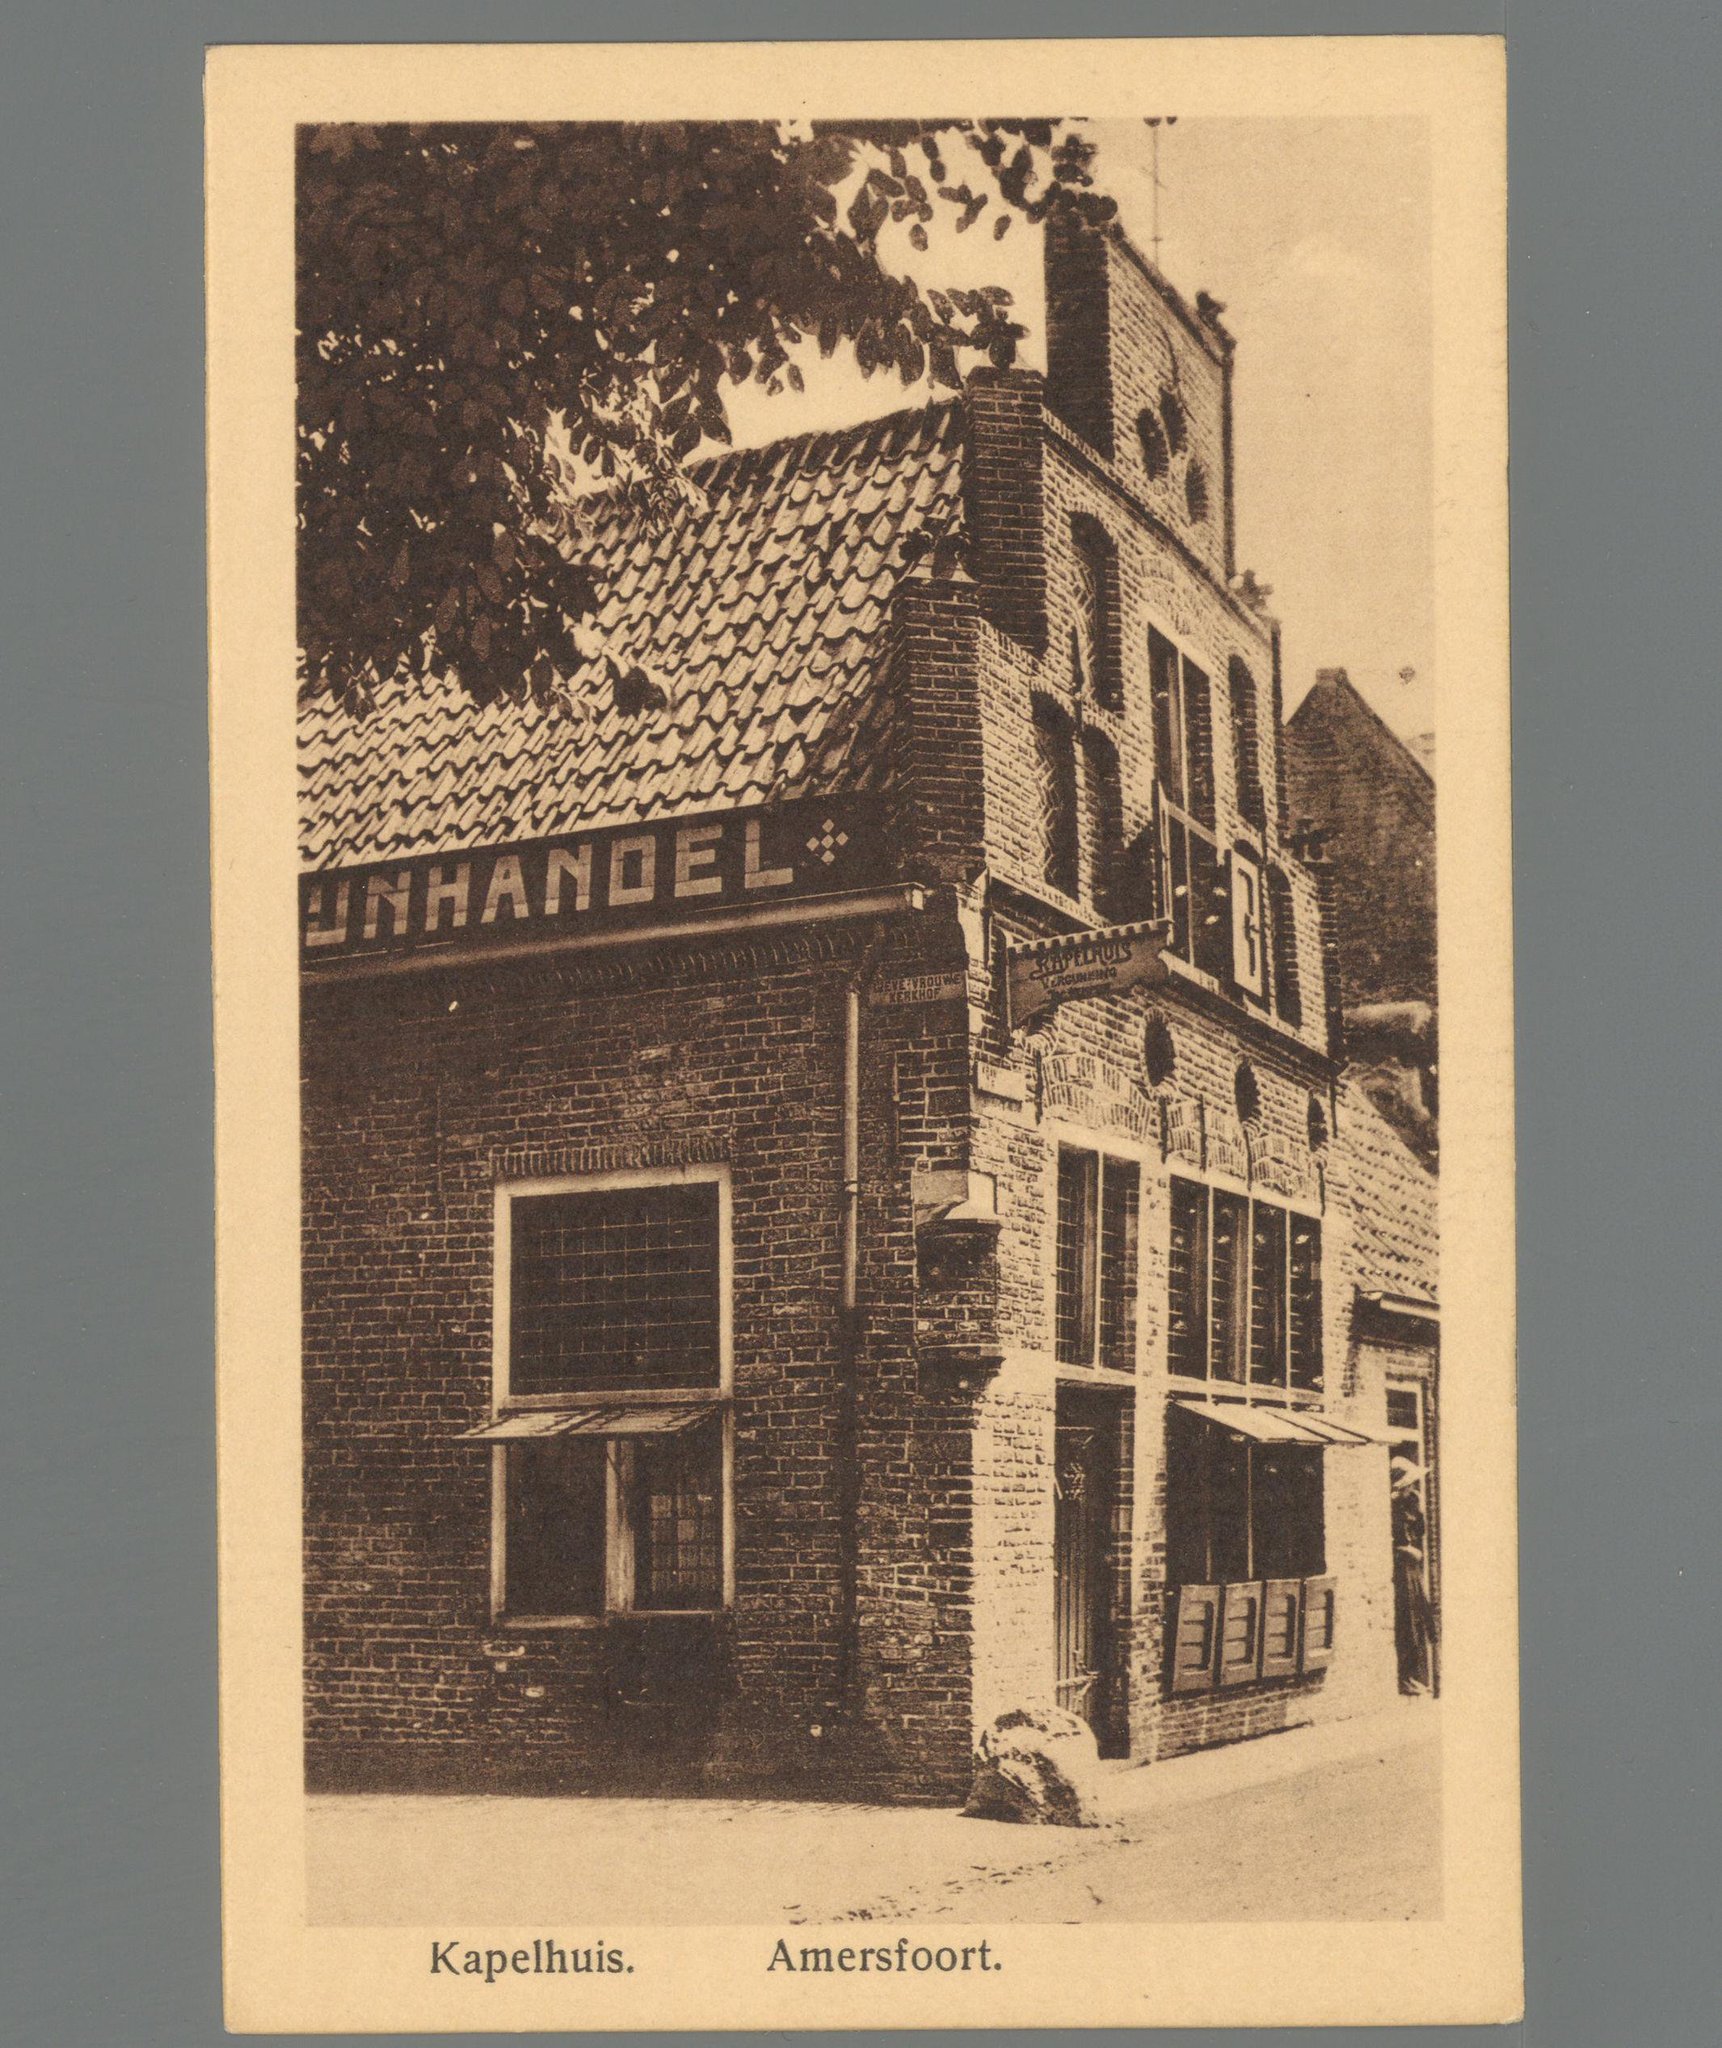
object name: ansichtkaart, prentbriefkaart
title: Kapelhuis. Amersfoort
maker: Anonymous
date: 1913-1930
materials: cardboard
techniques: photograph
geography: amersfoort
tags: house combined with shop